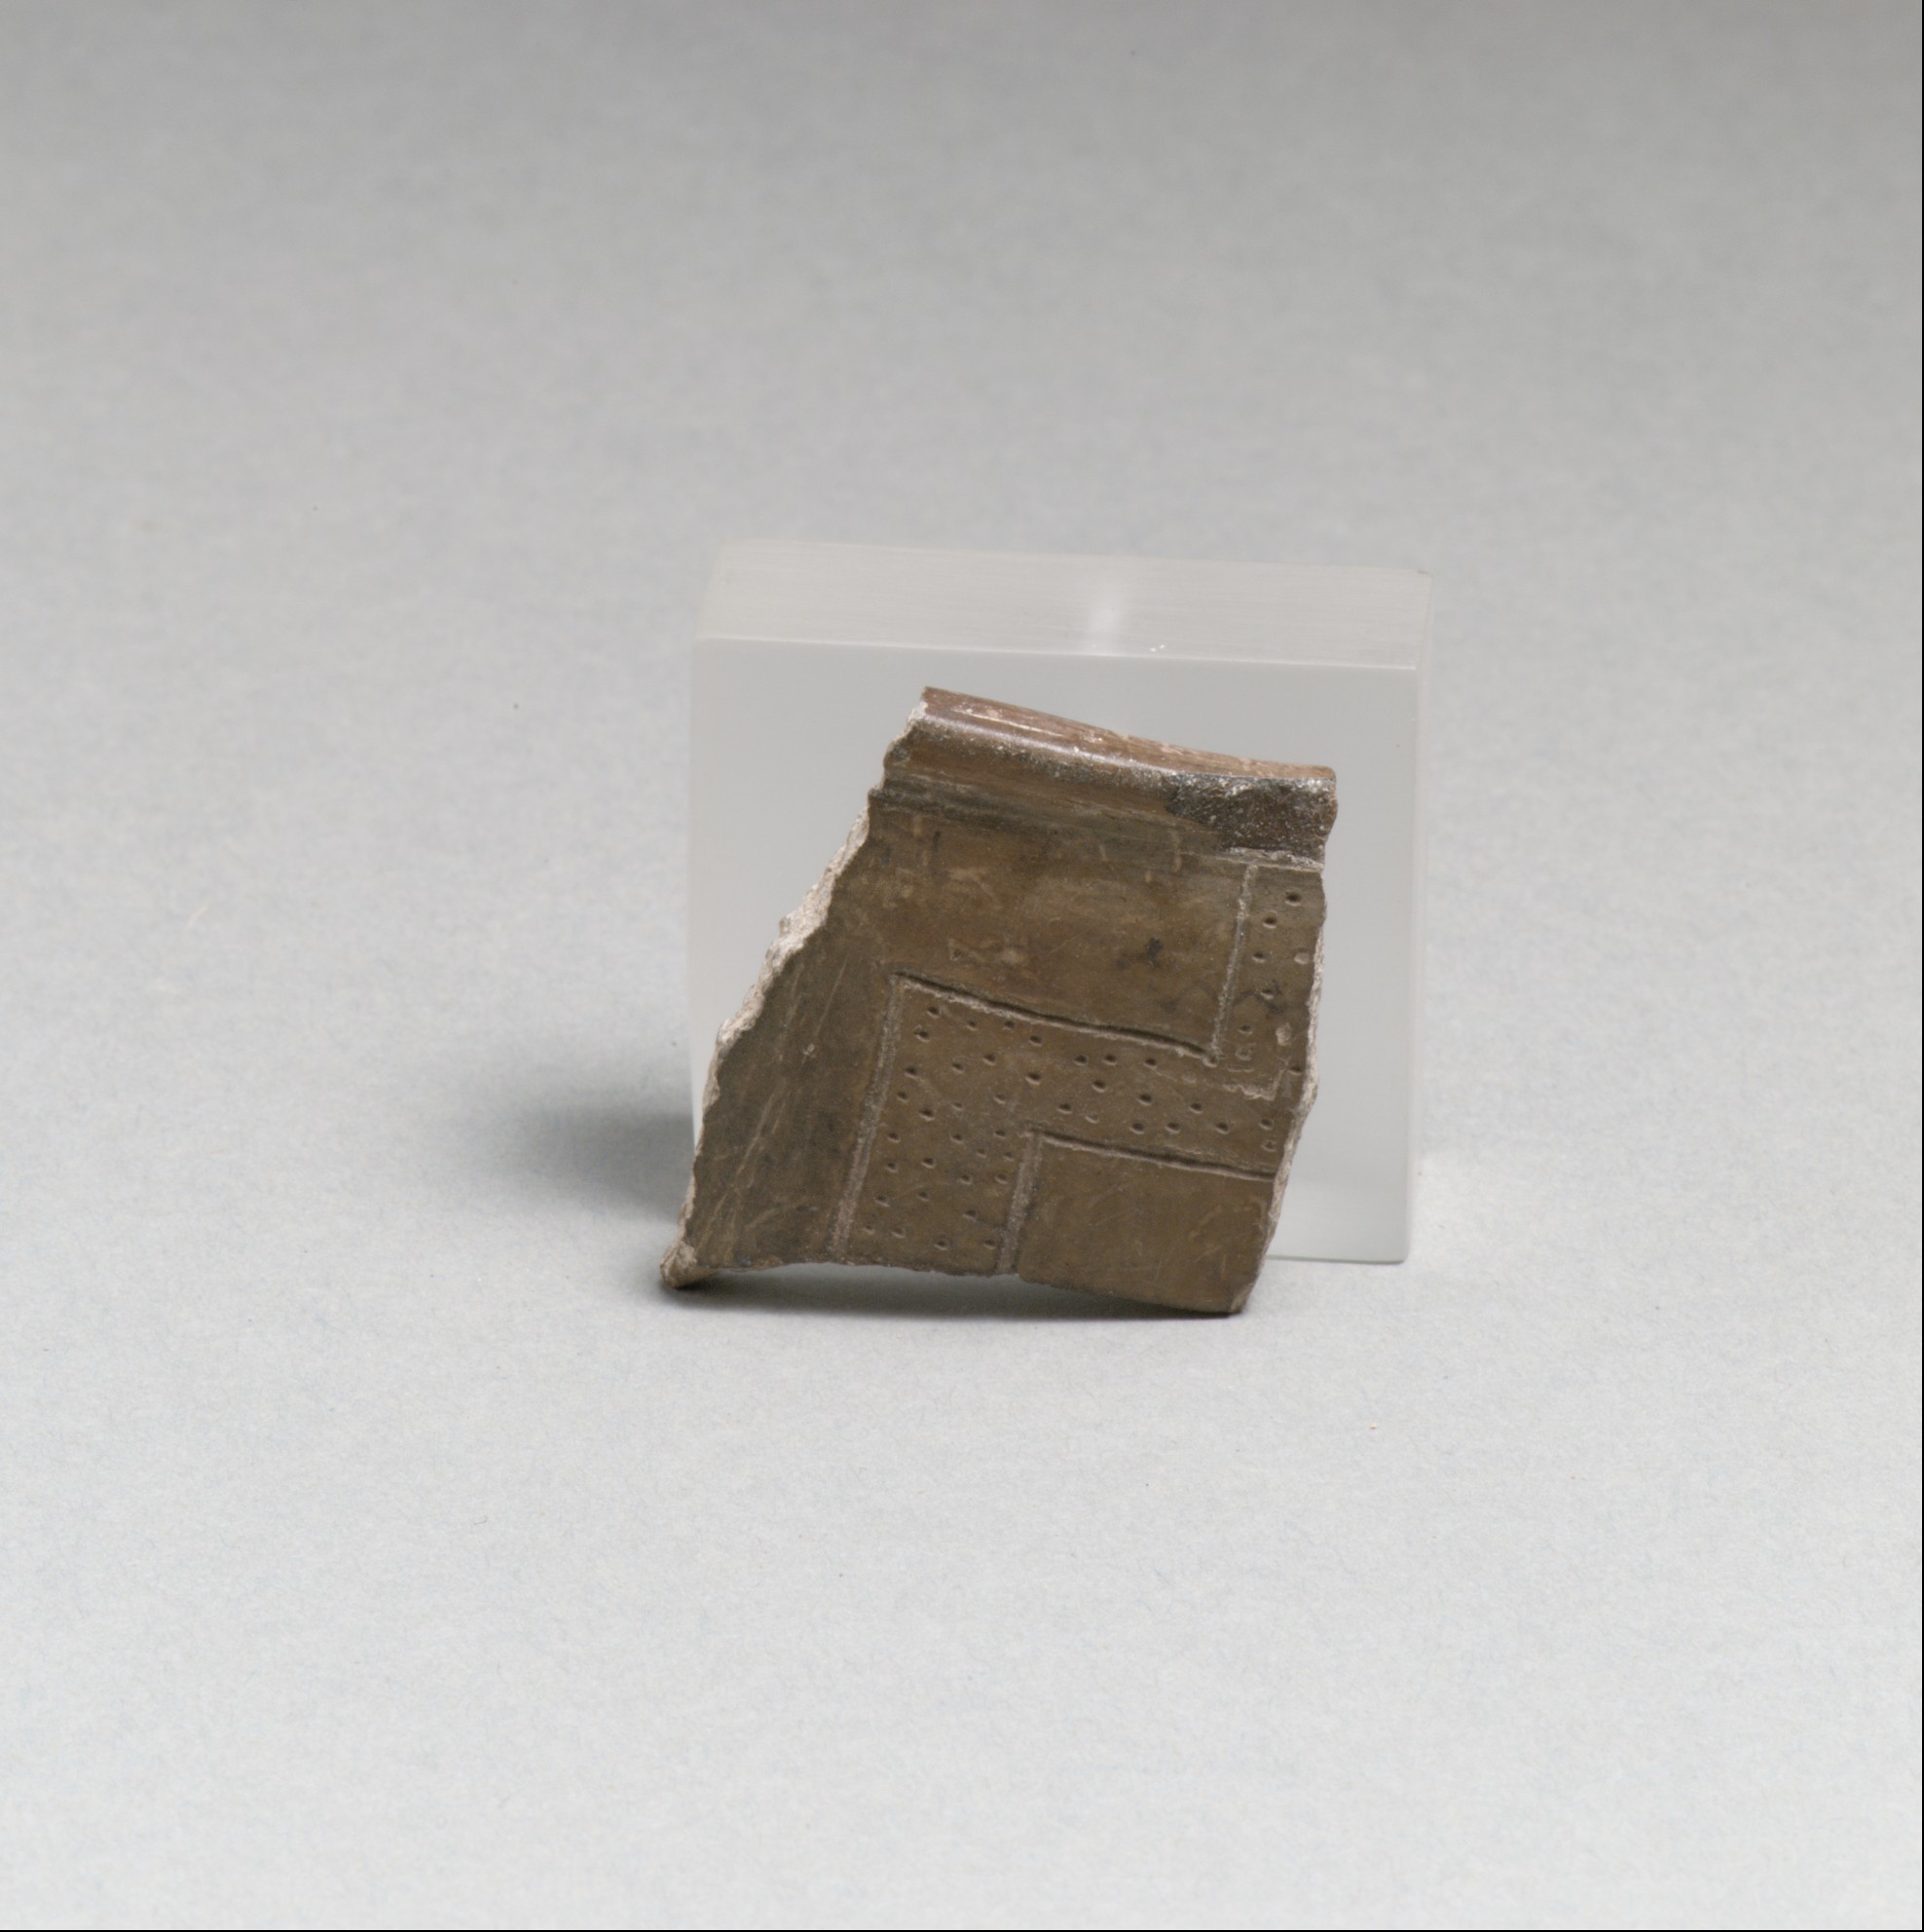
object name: vase fragment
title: Terracotta rim fragment with incised lines and punctations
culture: cretan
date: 3600-3100 BCE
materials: terracotta